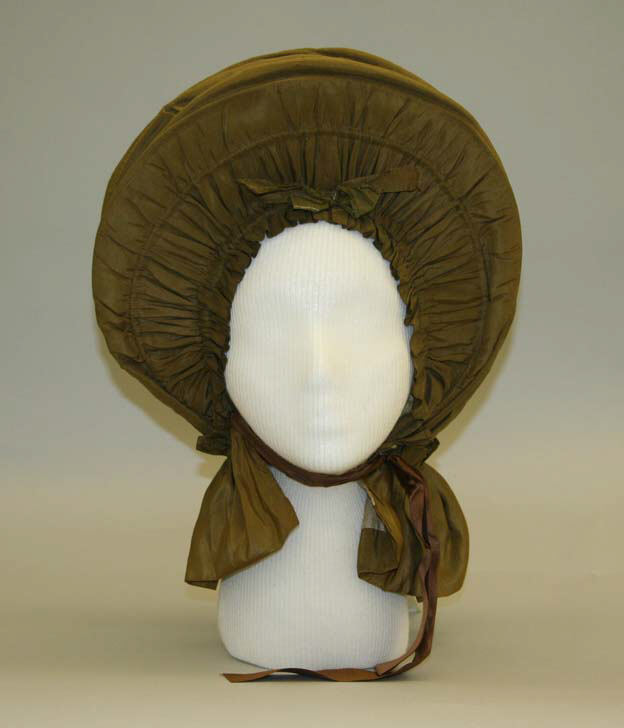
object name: calash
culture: american or european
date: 1835-1845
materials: silk